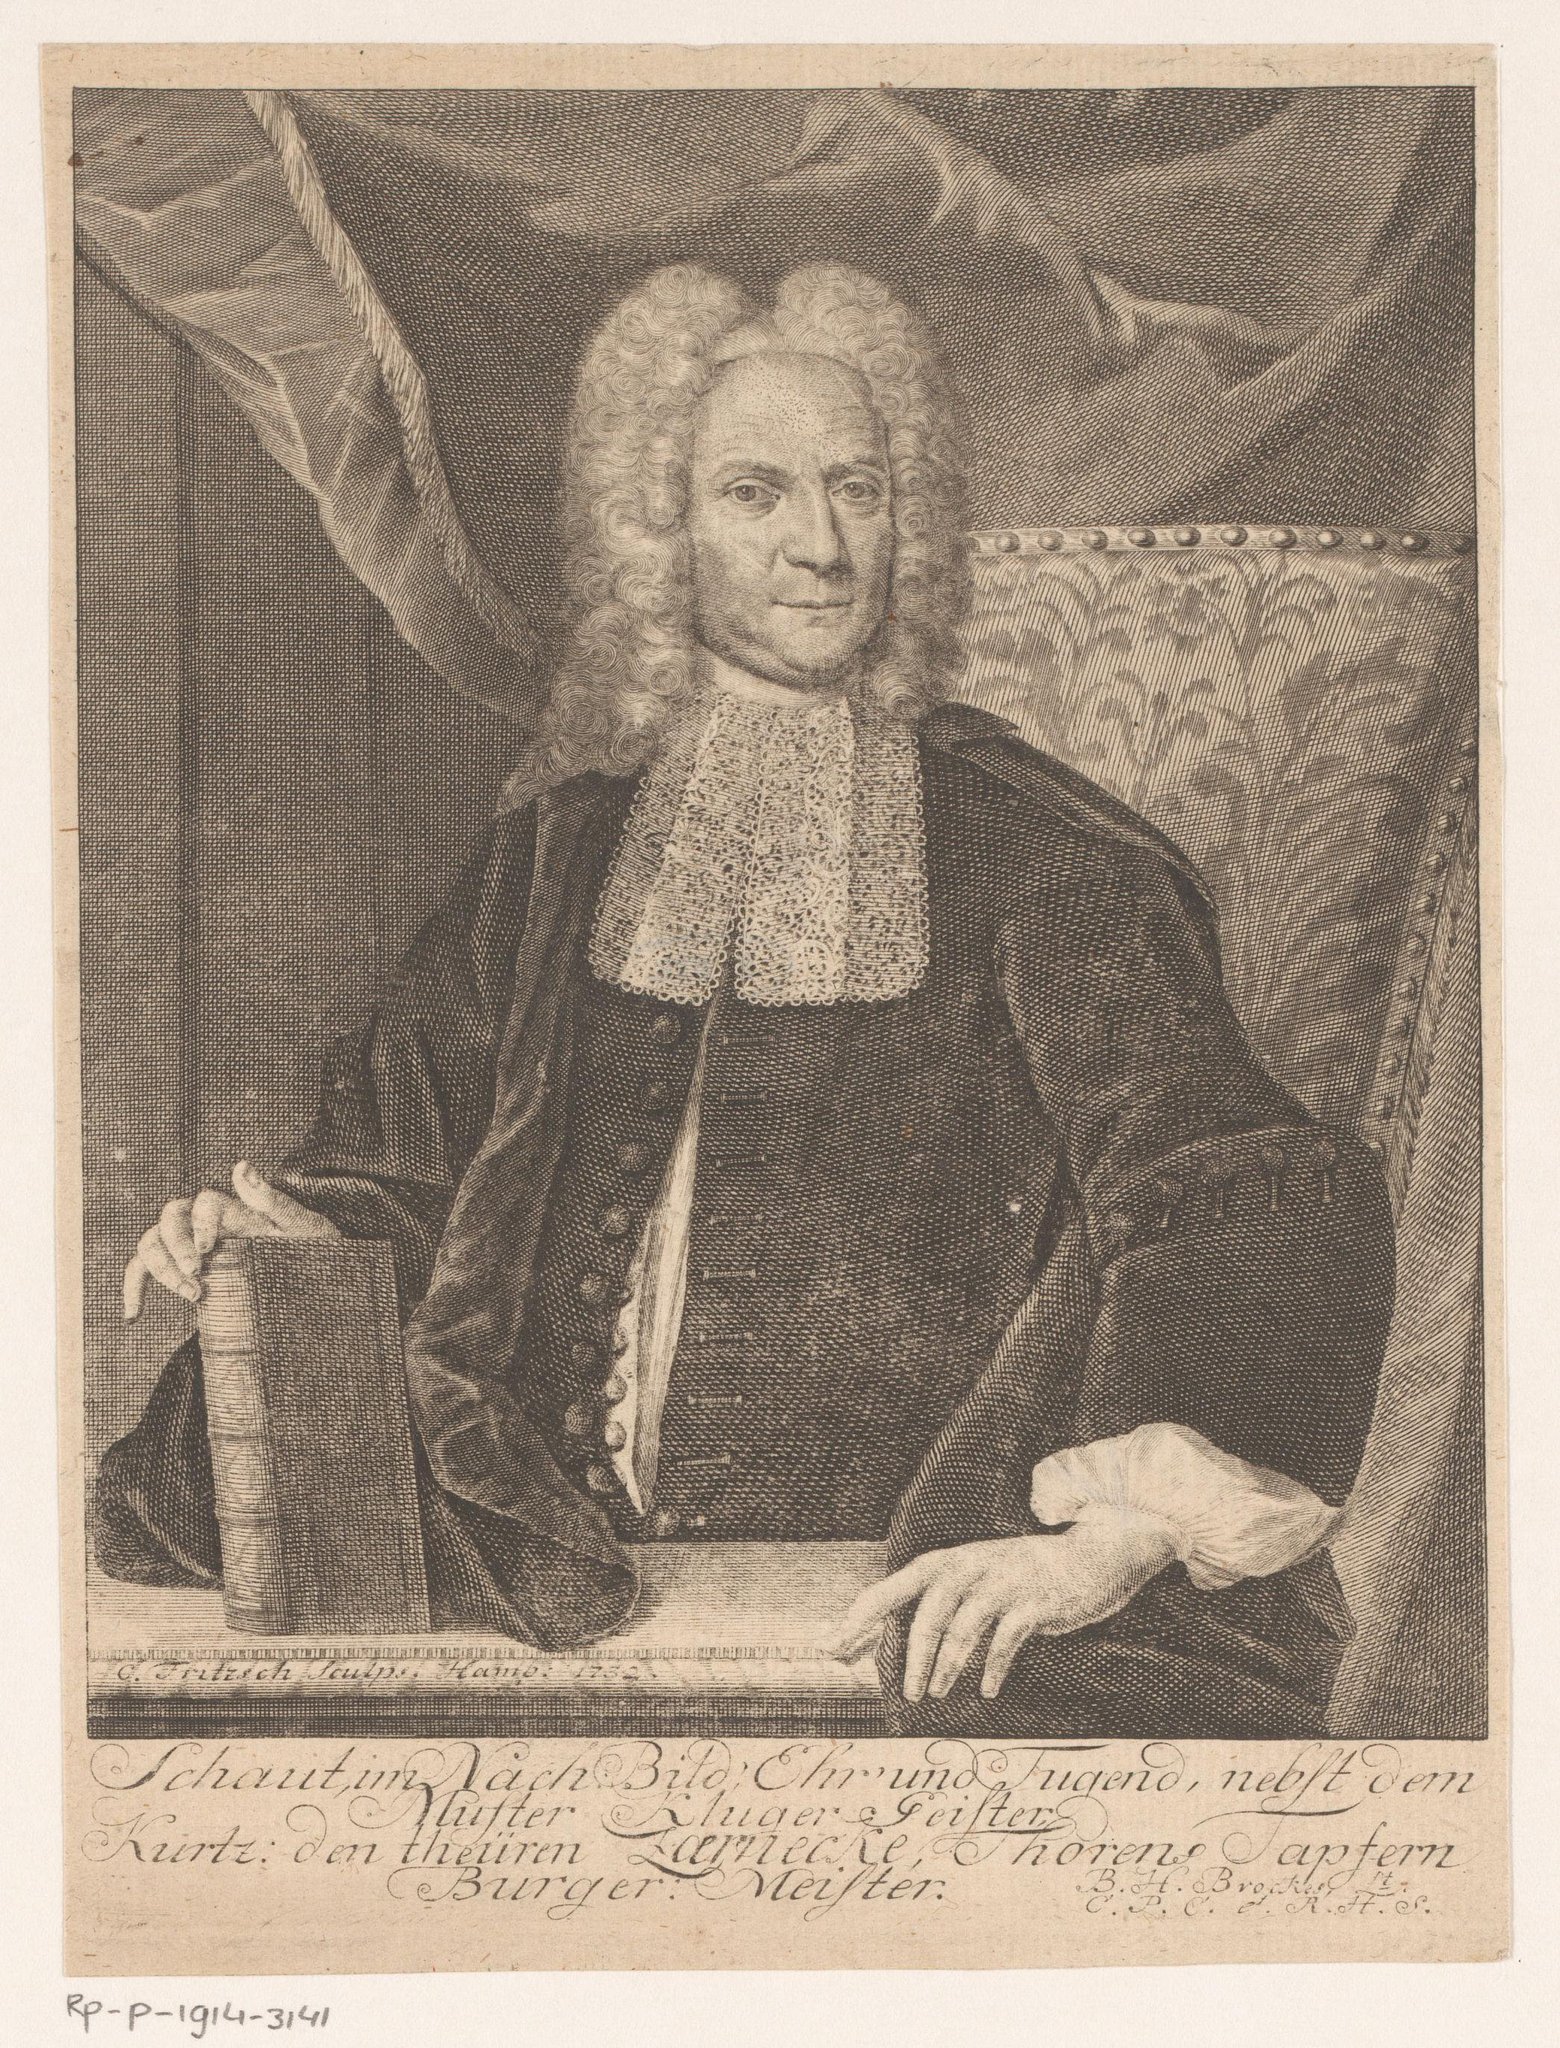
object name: print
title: Portret van Jacob Heinrich Zernecke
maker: christian fritzsch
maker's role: print maker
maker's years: 1695-1769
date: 1732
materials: paper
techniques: engraving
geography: hamburg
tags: mayor, historical persons, book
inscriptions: collector's mark: Lugt 2228